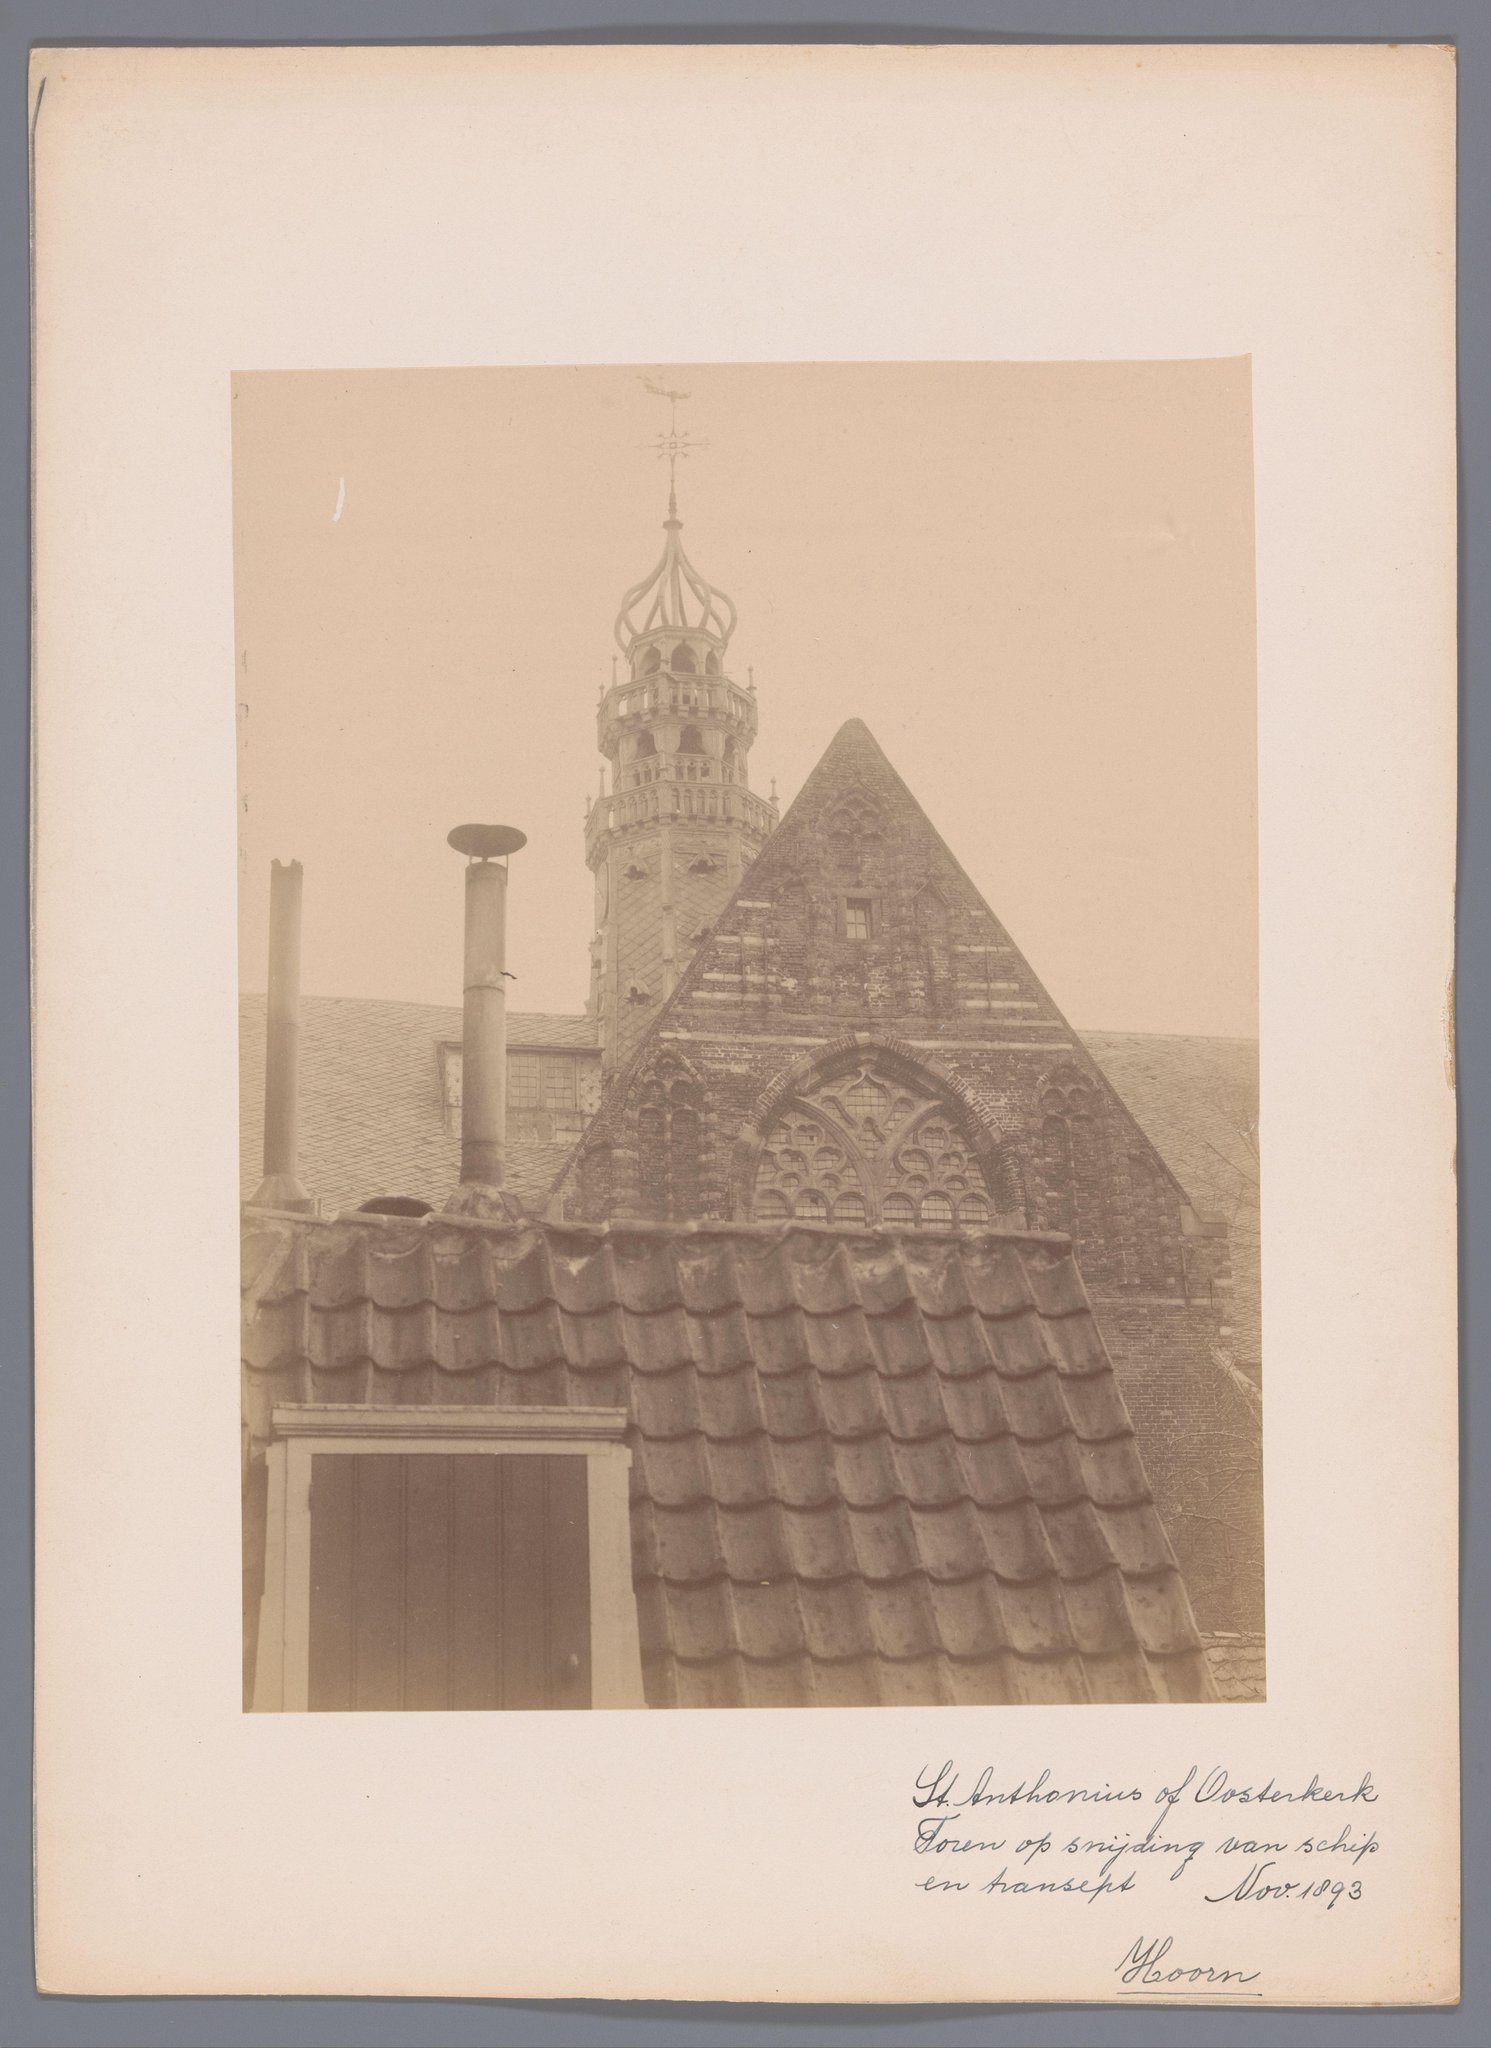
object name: photograph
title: Toren van de Oosterkerk te Hoorn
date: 1893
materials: cardboard, photographic support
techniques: albumen print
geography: hoorn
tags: church (exterior), tower (of house or building)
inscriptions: annotation: ‘St. Anthonius of Oosterkerk/ Toren op snijding van het schip en transept/ Nov. 1893/ Hoorn’, annotation: ‘Hoorn/ Toren op snijding van schip en transept/ Oosterkerk/ Nov. 1893’